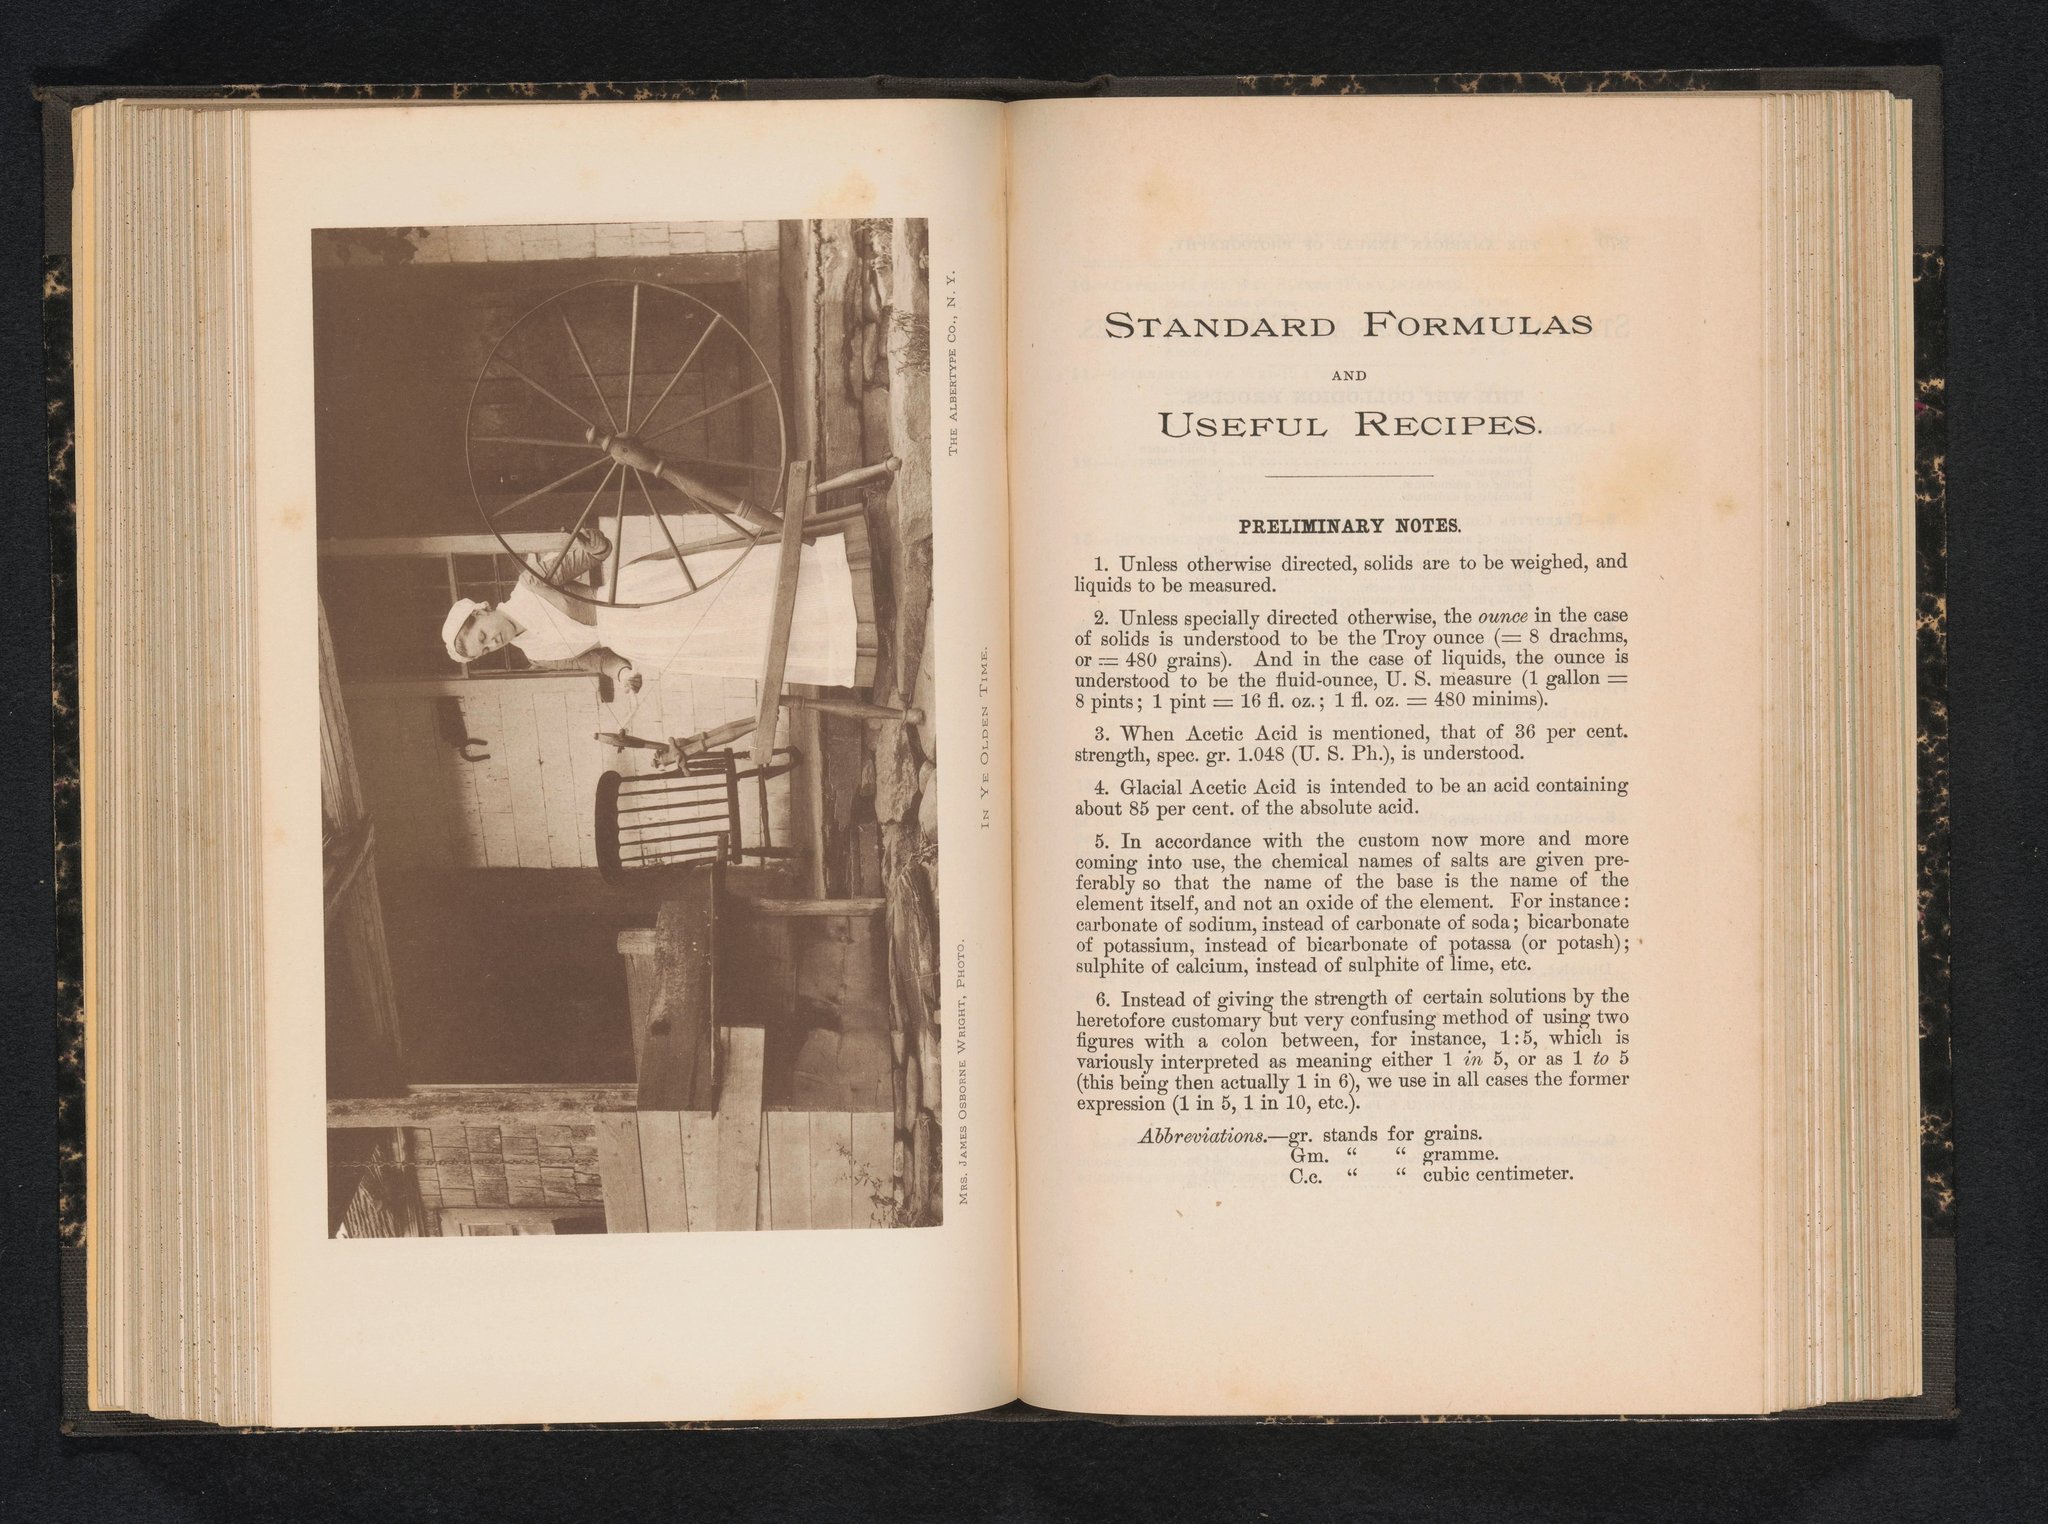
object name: photomechanical print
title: In ye olden time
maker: james osborne wright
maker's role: fotograaf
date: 1887-1907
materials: paper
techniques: photograph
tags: historical persons - bb - woman, spinning (manufacture of yarn)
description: Prent op tweede ongenummerde pagina na pagina 268.